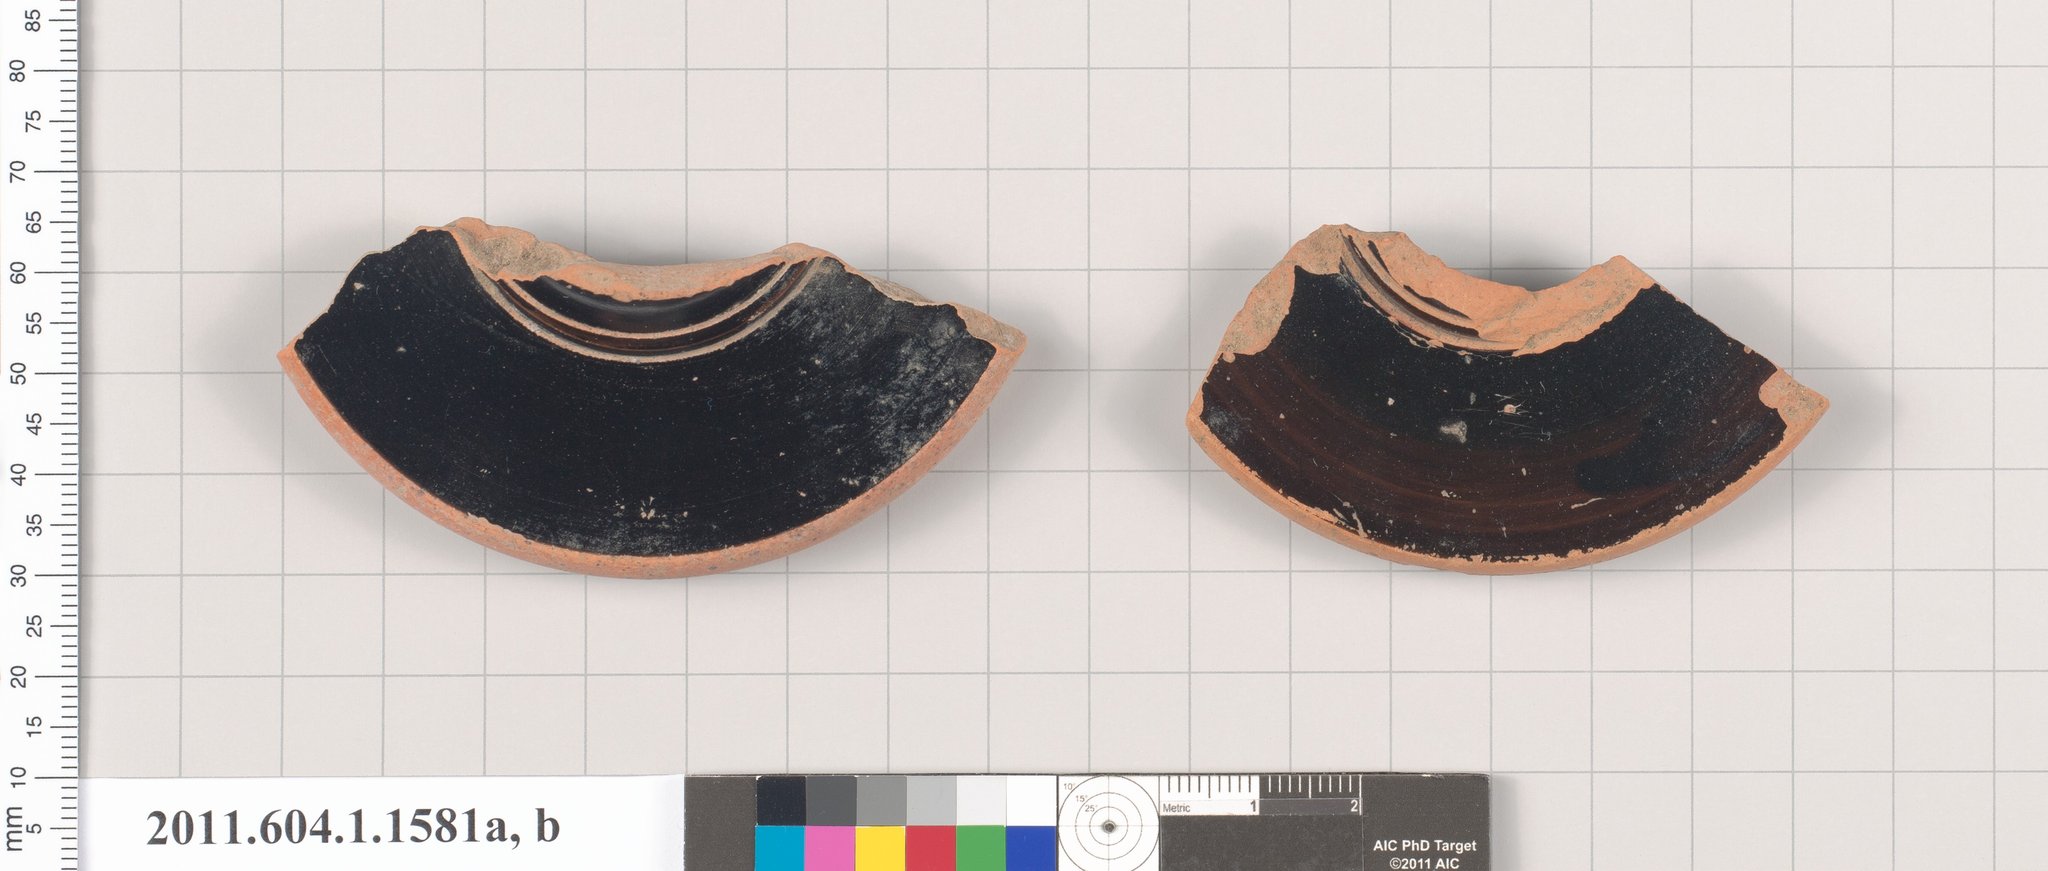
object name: kylix fragment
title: Terracotta fragments of kylikes (drinking cups)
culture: greek, attic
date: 500-401 BCE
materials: terracotta